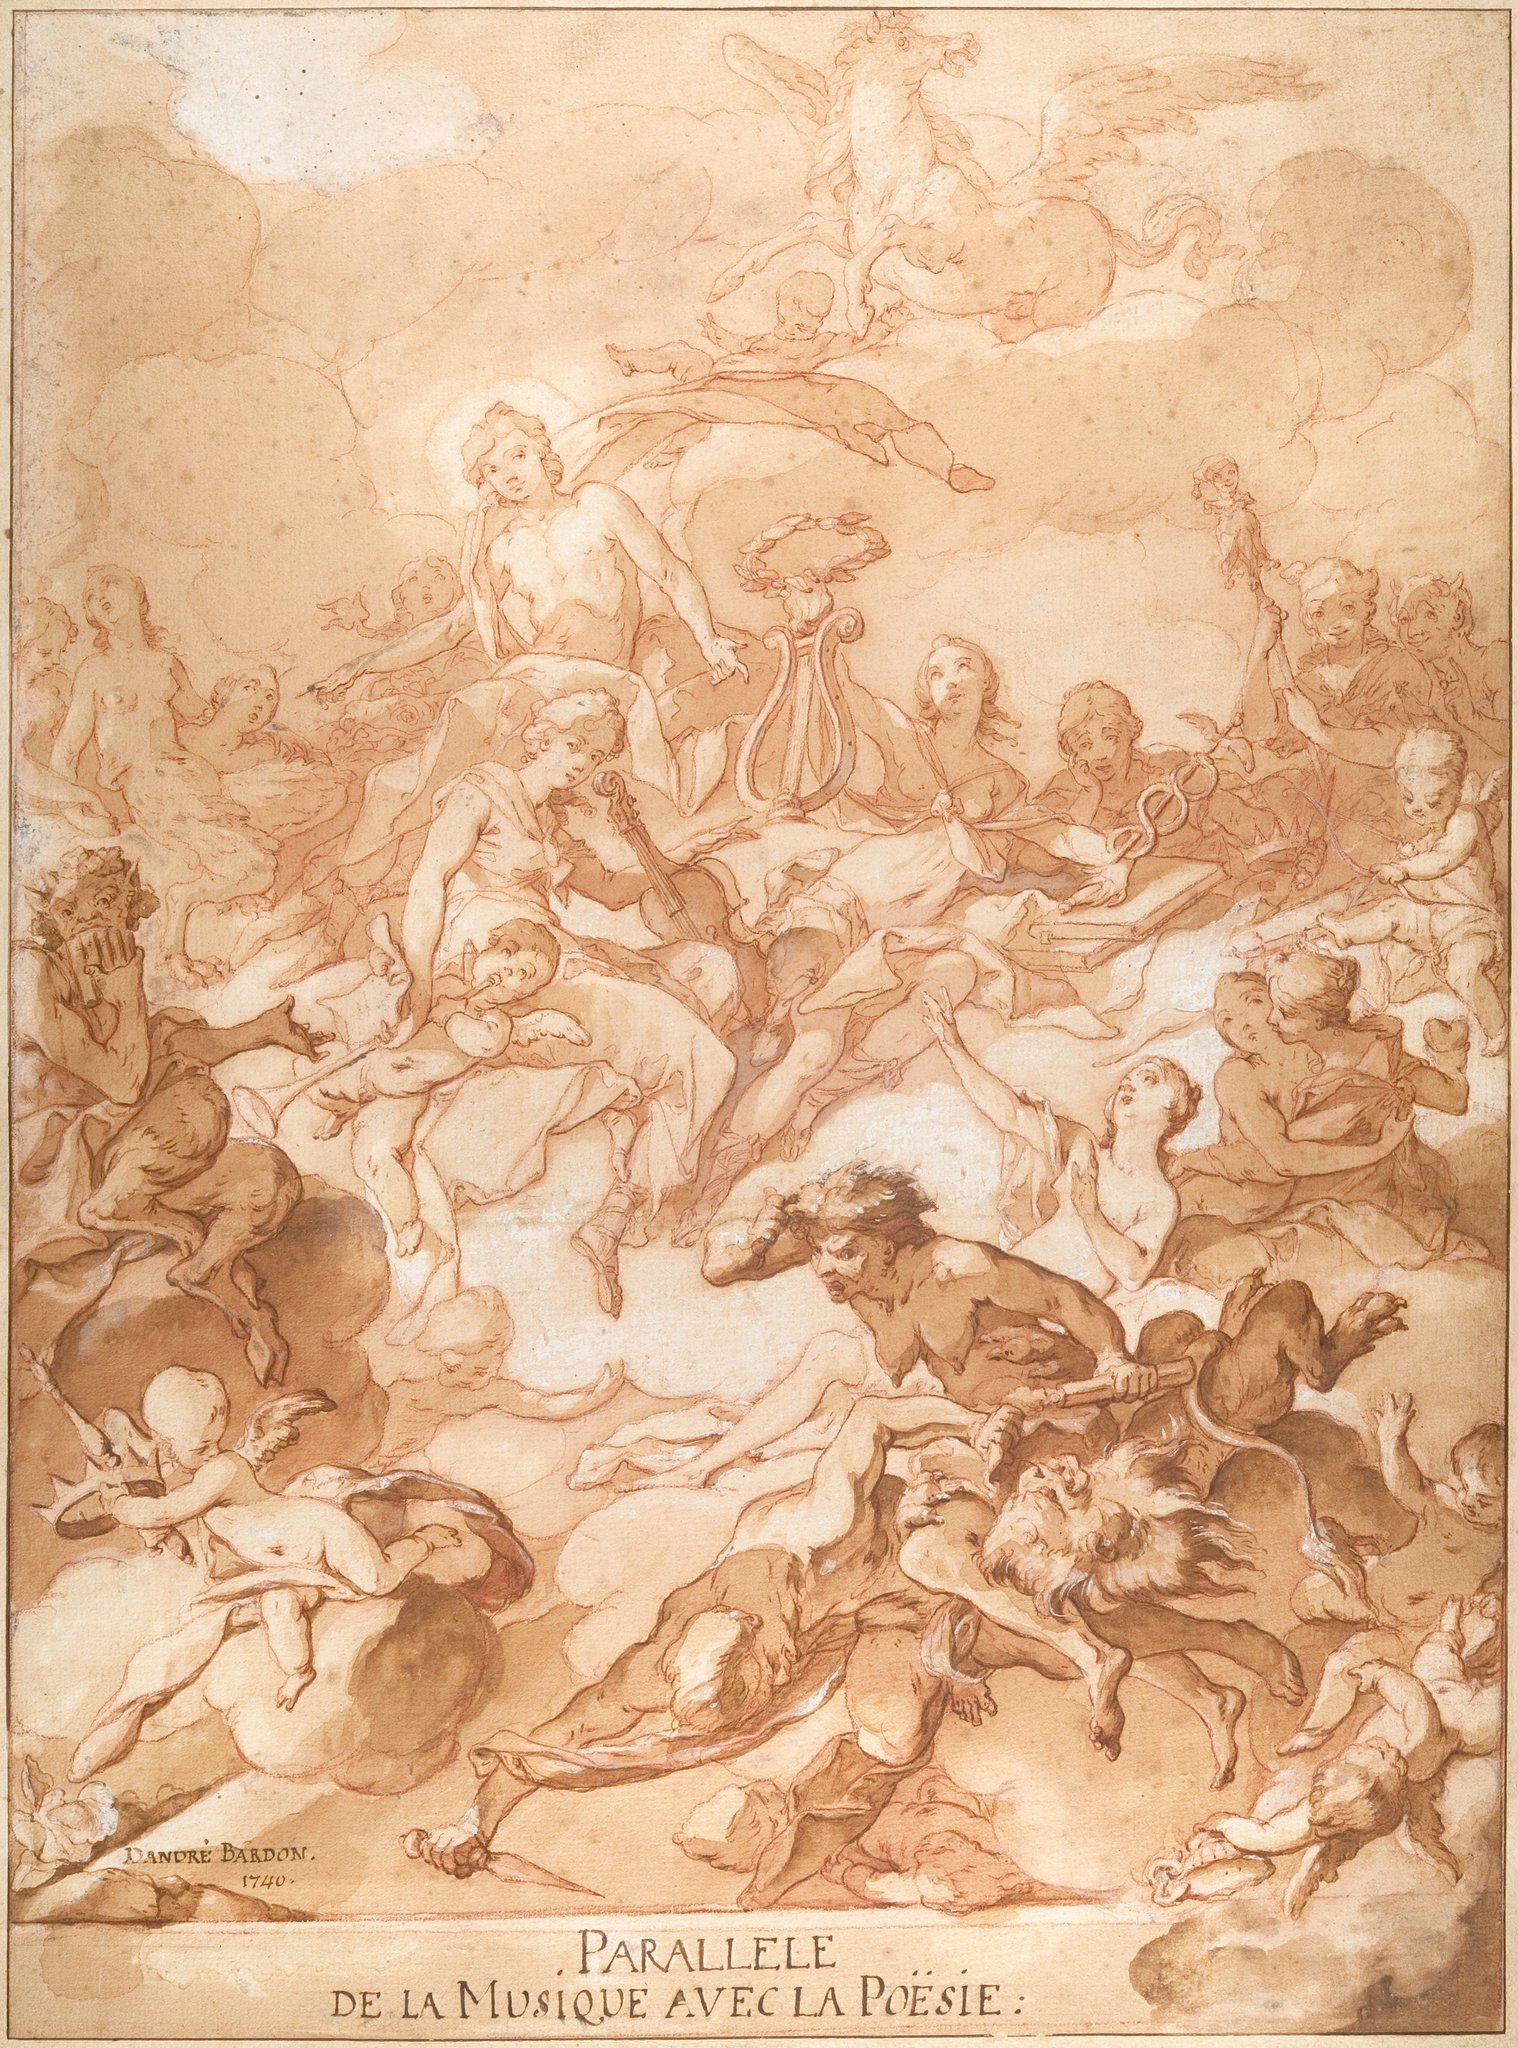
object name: drawing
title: An Allegory Comparing Music and Poetry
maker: michel françois dandré-bardon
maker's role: artist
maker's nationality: french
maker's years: 1700-1783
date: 1740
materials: chalk, gouache, ink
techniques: brush, heightening, pen, wash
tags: male nudes,female nudes,harps,centaurs,pegasus